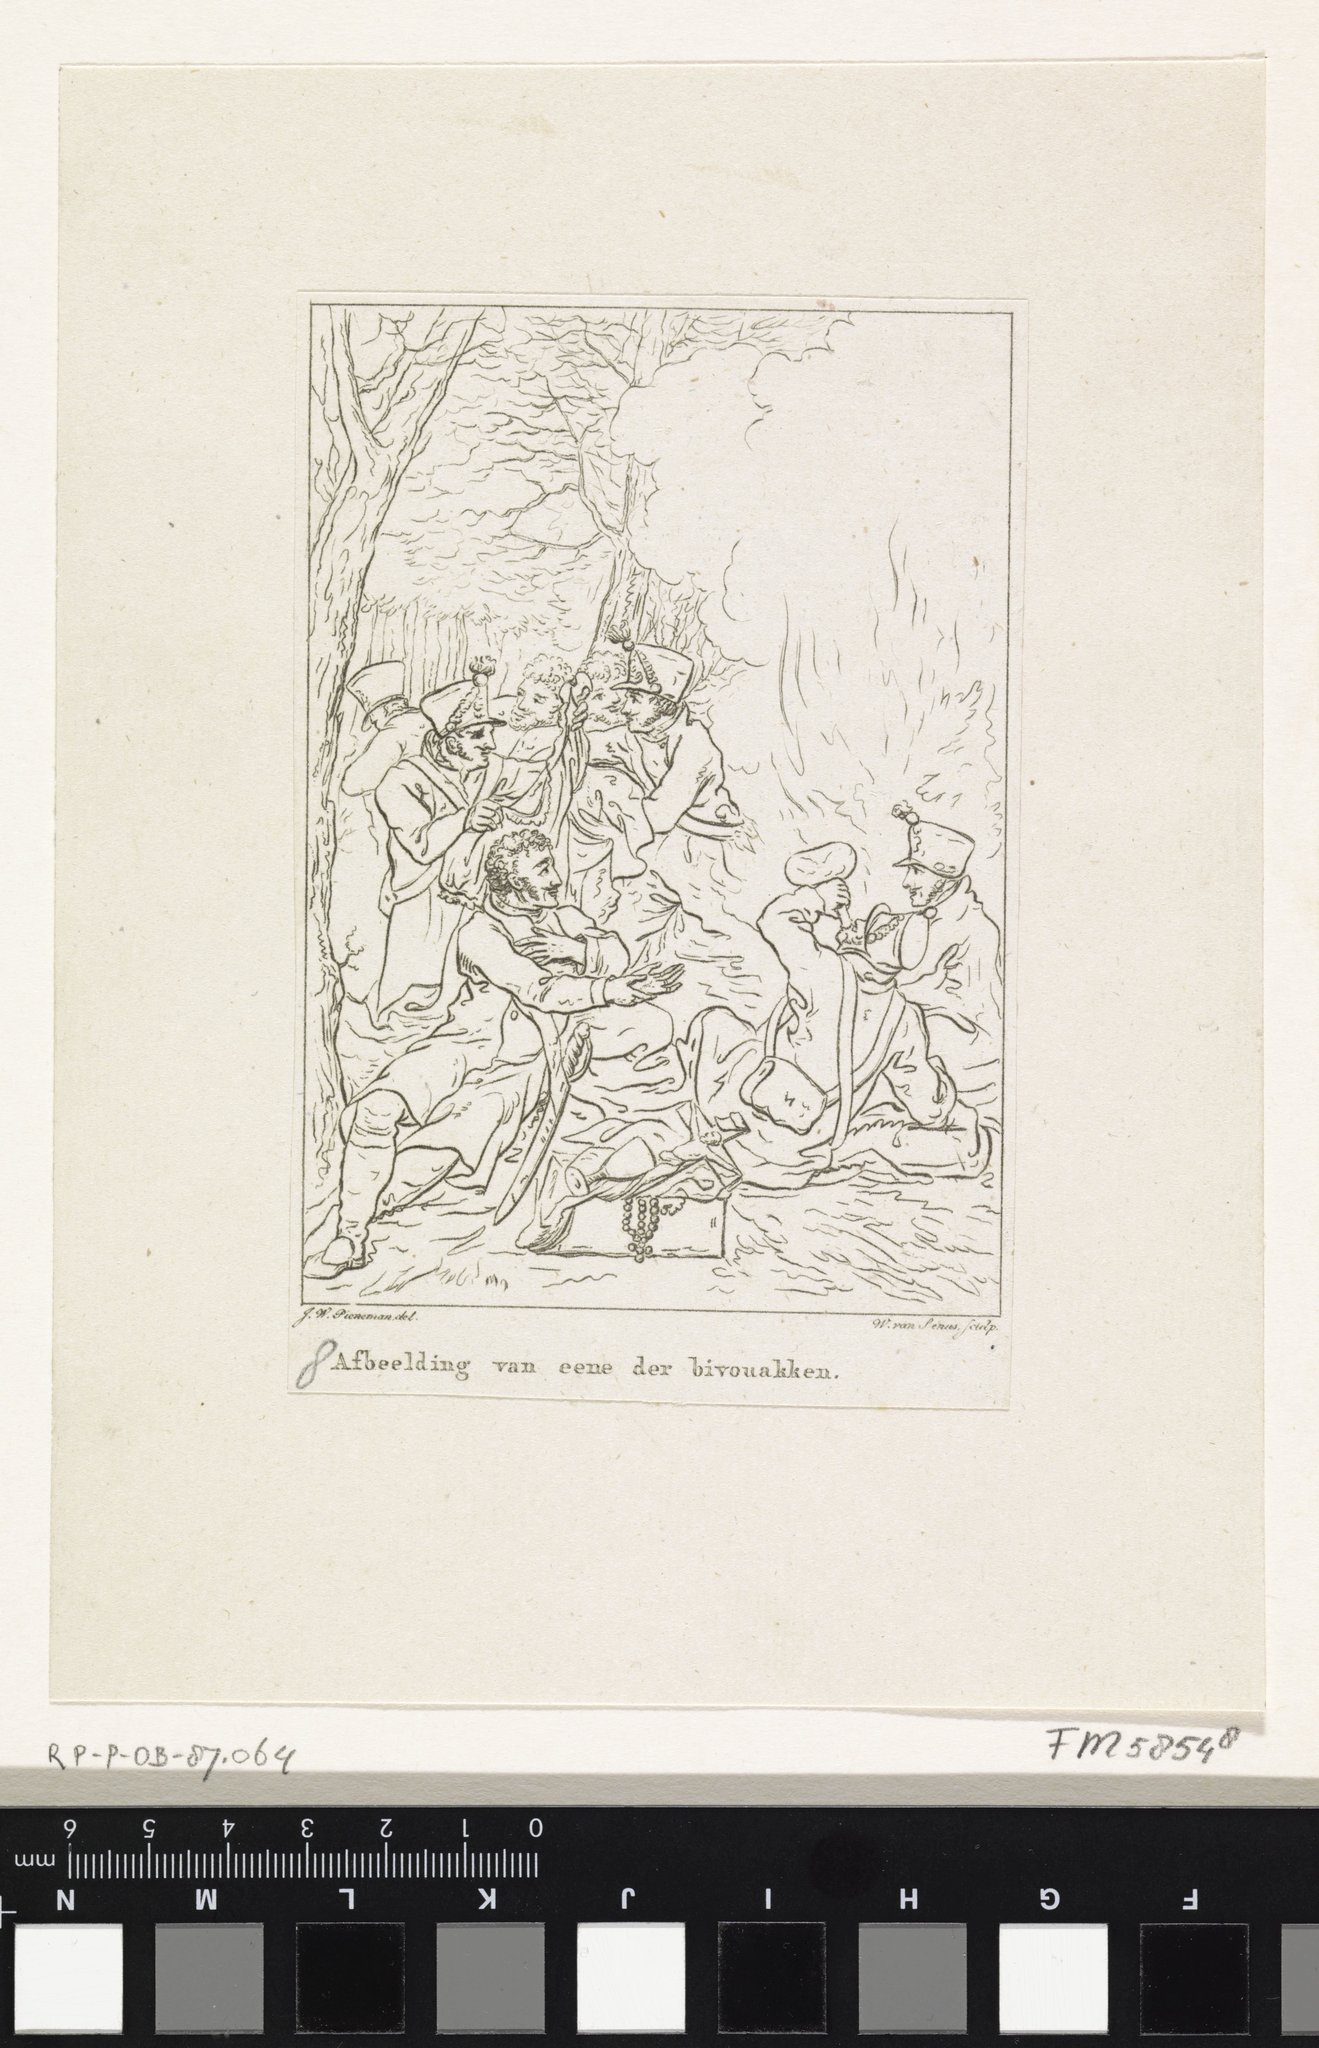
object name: print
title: Bivak van Fransen te Woerden, 1813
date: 1813-1814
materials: paper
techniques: etching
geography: netherlands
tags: (military) camp with tents, plundering ~ soldiers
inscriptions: collector's mark: Lugt 2228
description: Bivak van Franse militairen na hun plunderingen in Woerden. Onderdeel van een groep illustraties in omtrek van de gruwelijkheden begaan door de Franse troepen tijdens de overrompeling en plundering van Woerden op 24 en 25 november 1813.